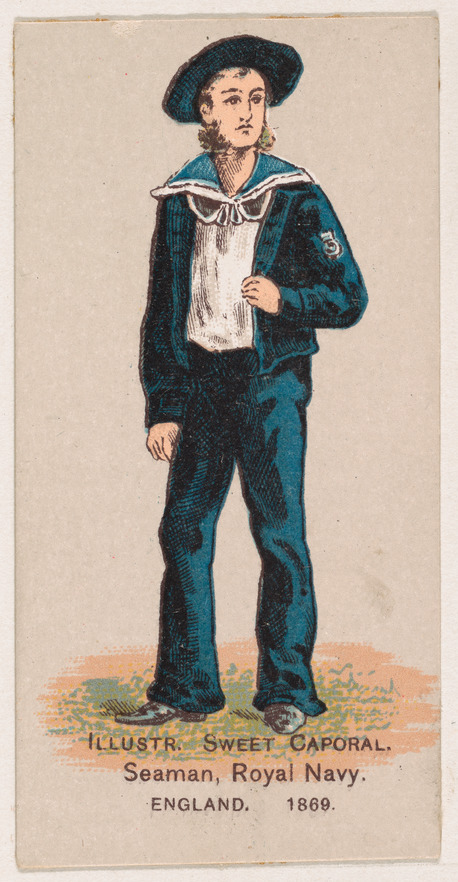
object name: print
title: Seaman, Royal Navy, England, 1869, from the Military Series (N224) issued by Kinney Tobacco Company to promote Sweet Caporal Cigarettes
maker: kinney brothers tobacco company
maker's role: publisher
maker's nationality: american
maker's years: 1869-2011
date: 1888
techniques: color lithograph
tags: military,soldiers,men